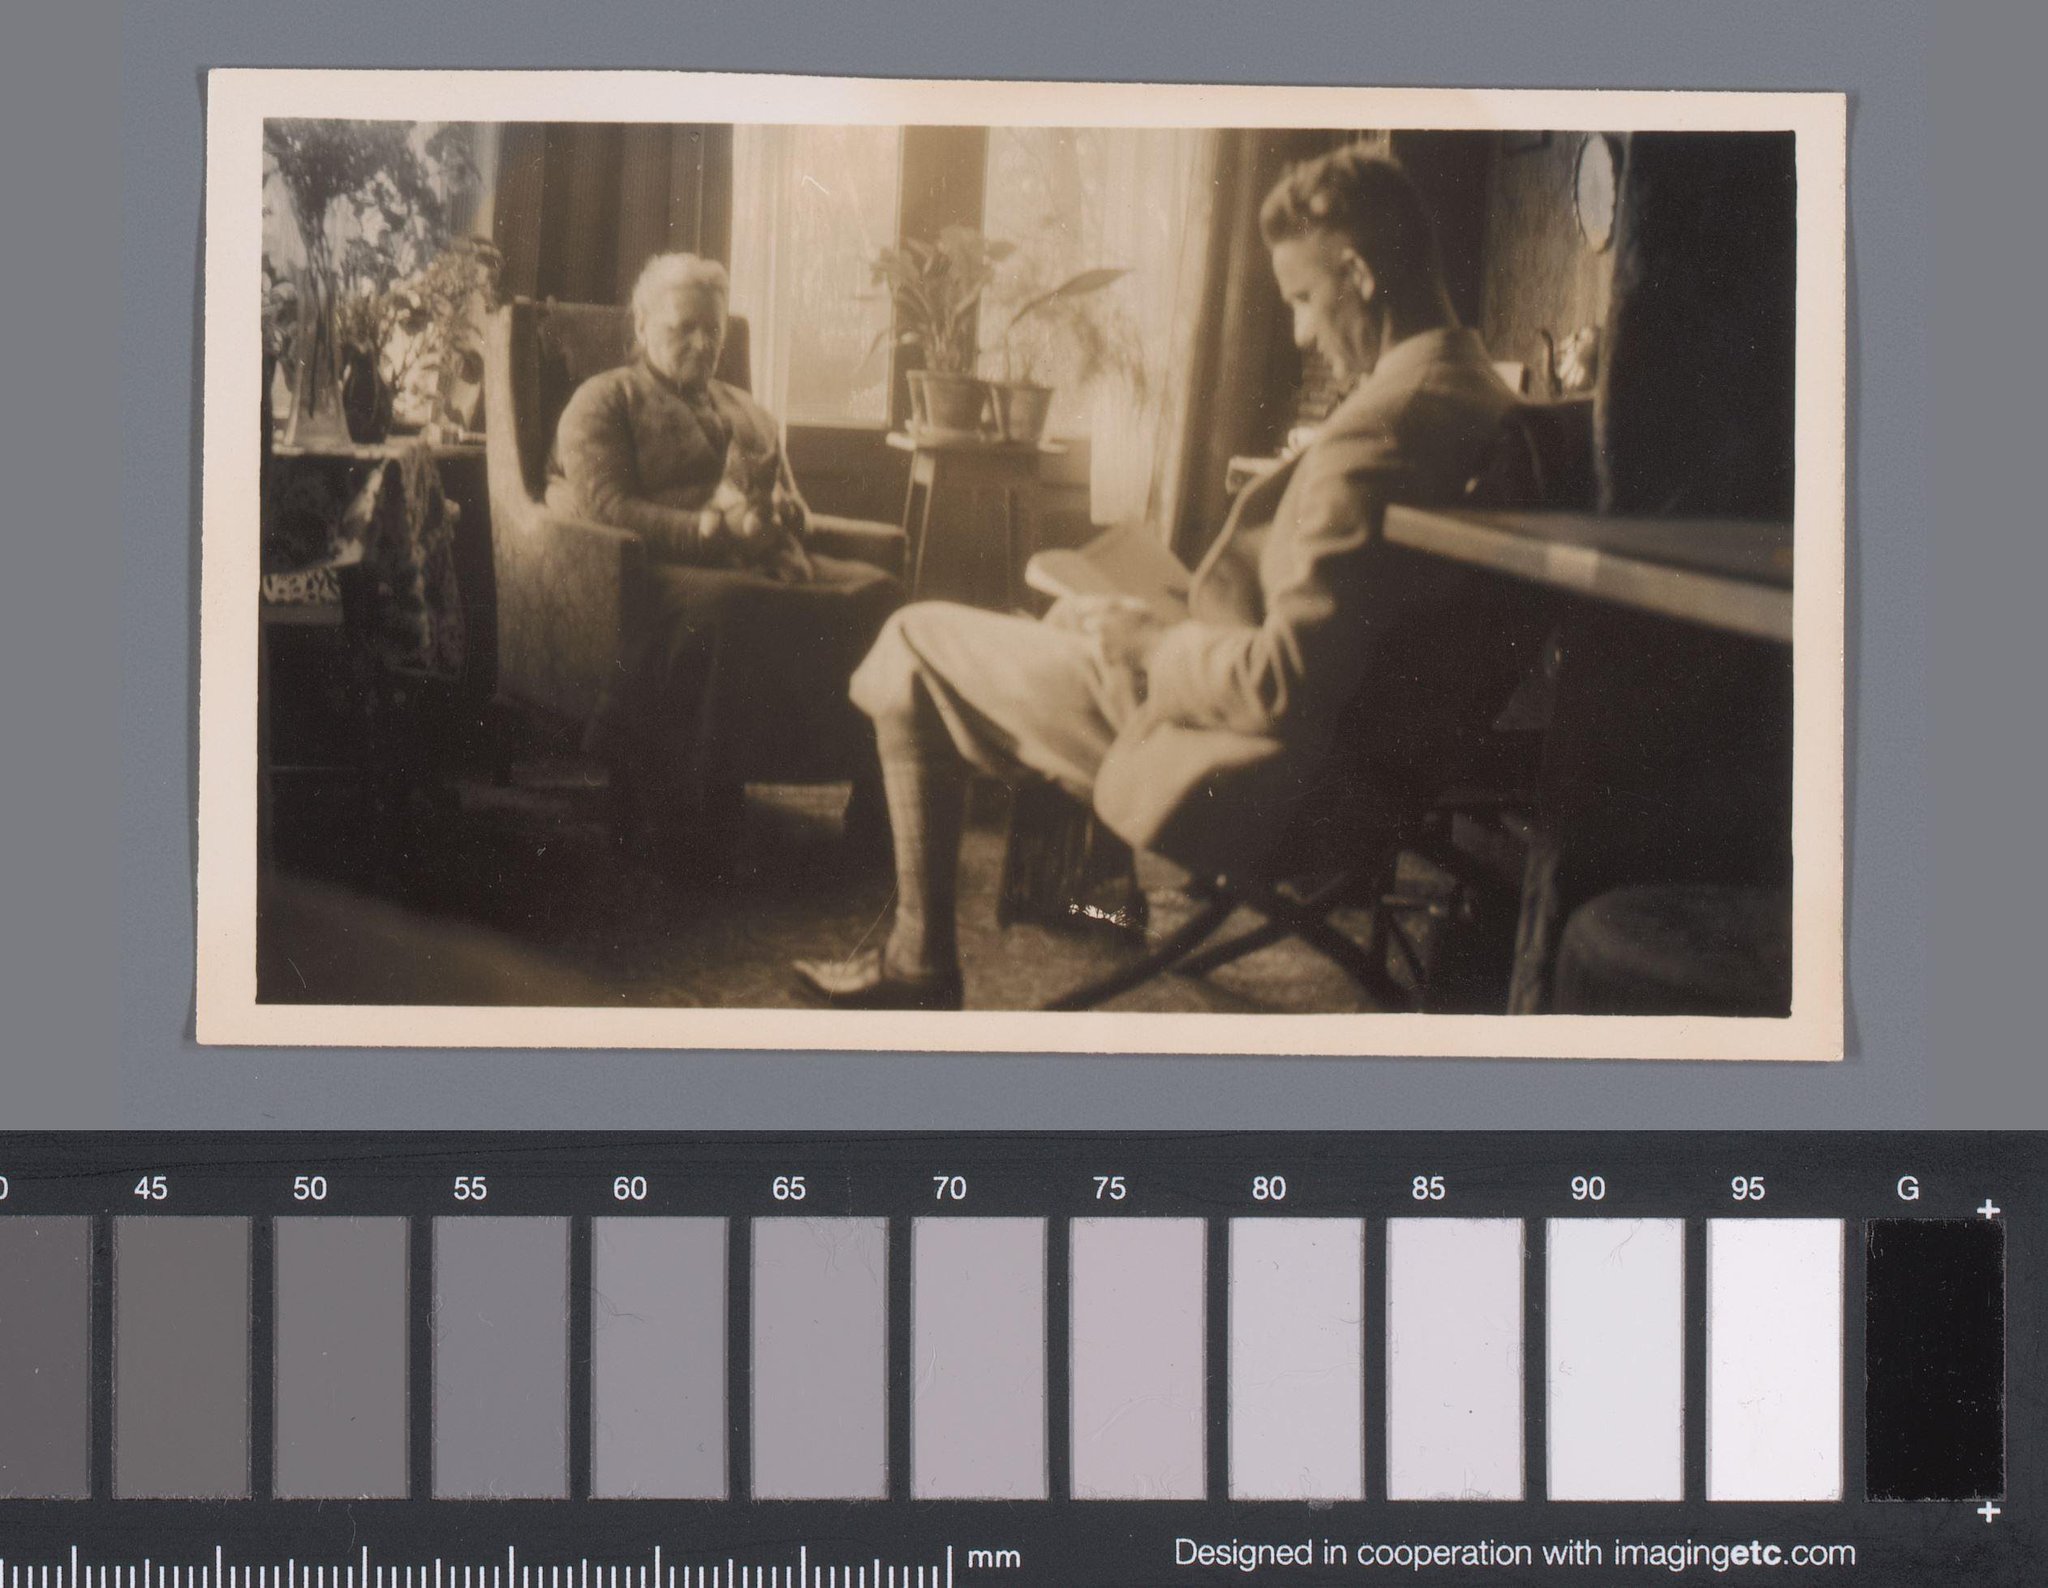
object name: photograph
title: Portret van twee onbekende personen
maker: Anonymous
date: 1910-1940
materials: photographic support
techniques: gelatin silver print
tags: anonymous historical persons portrayed in a group, in a group-portrait